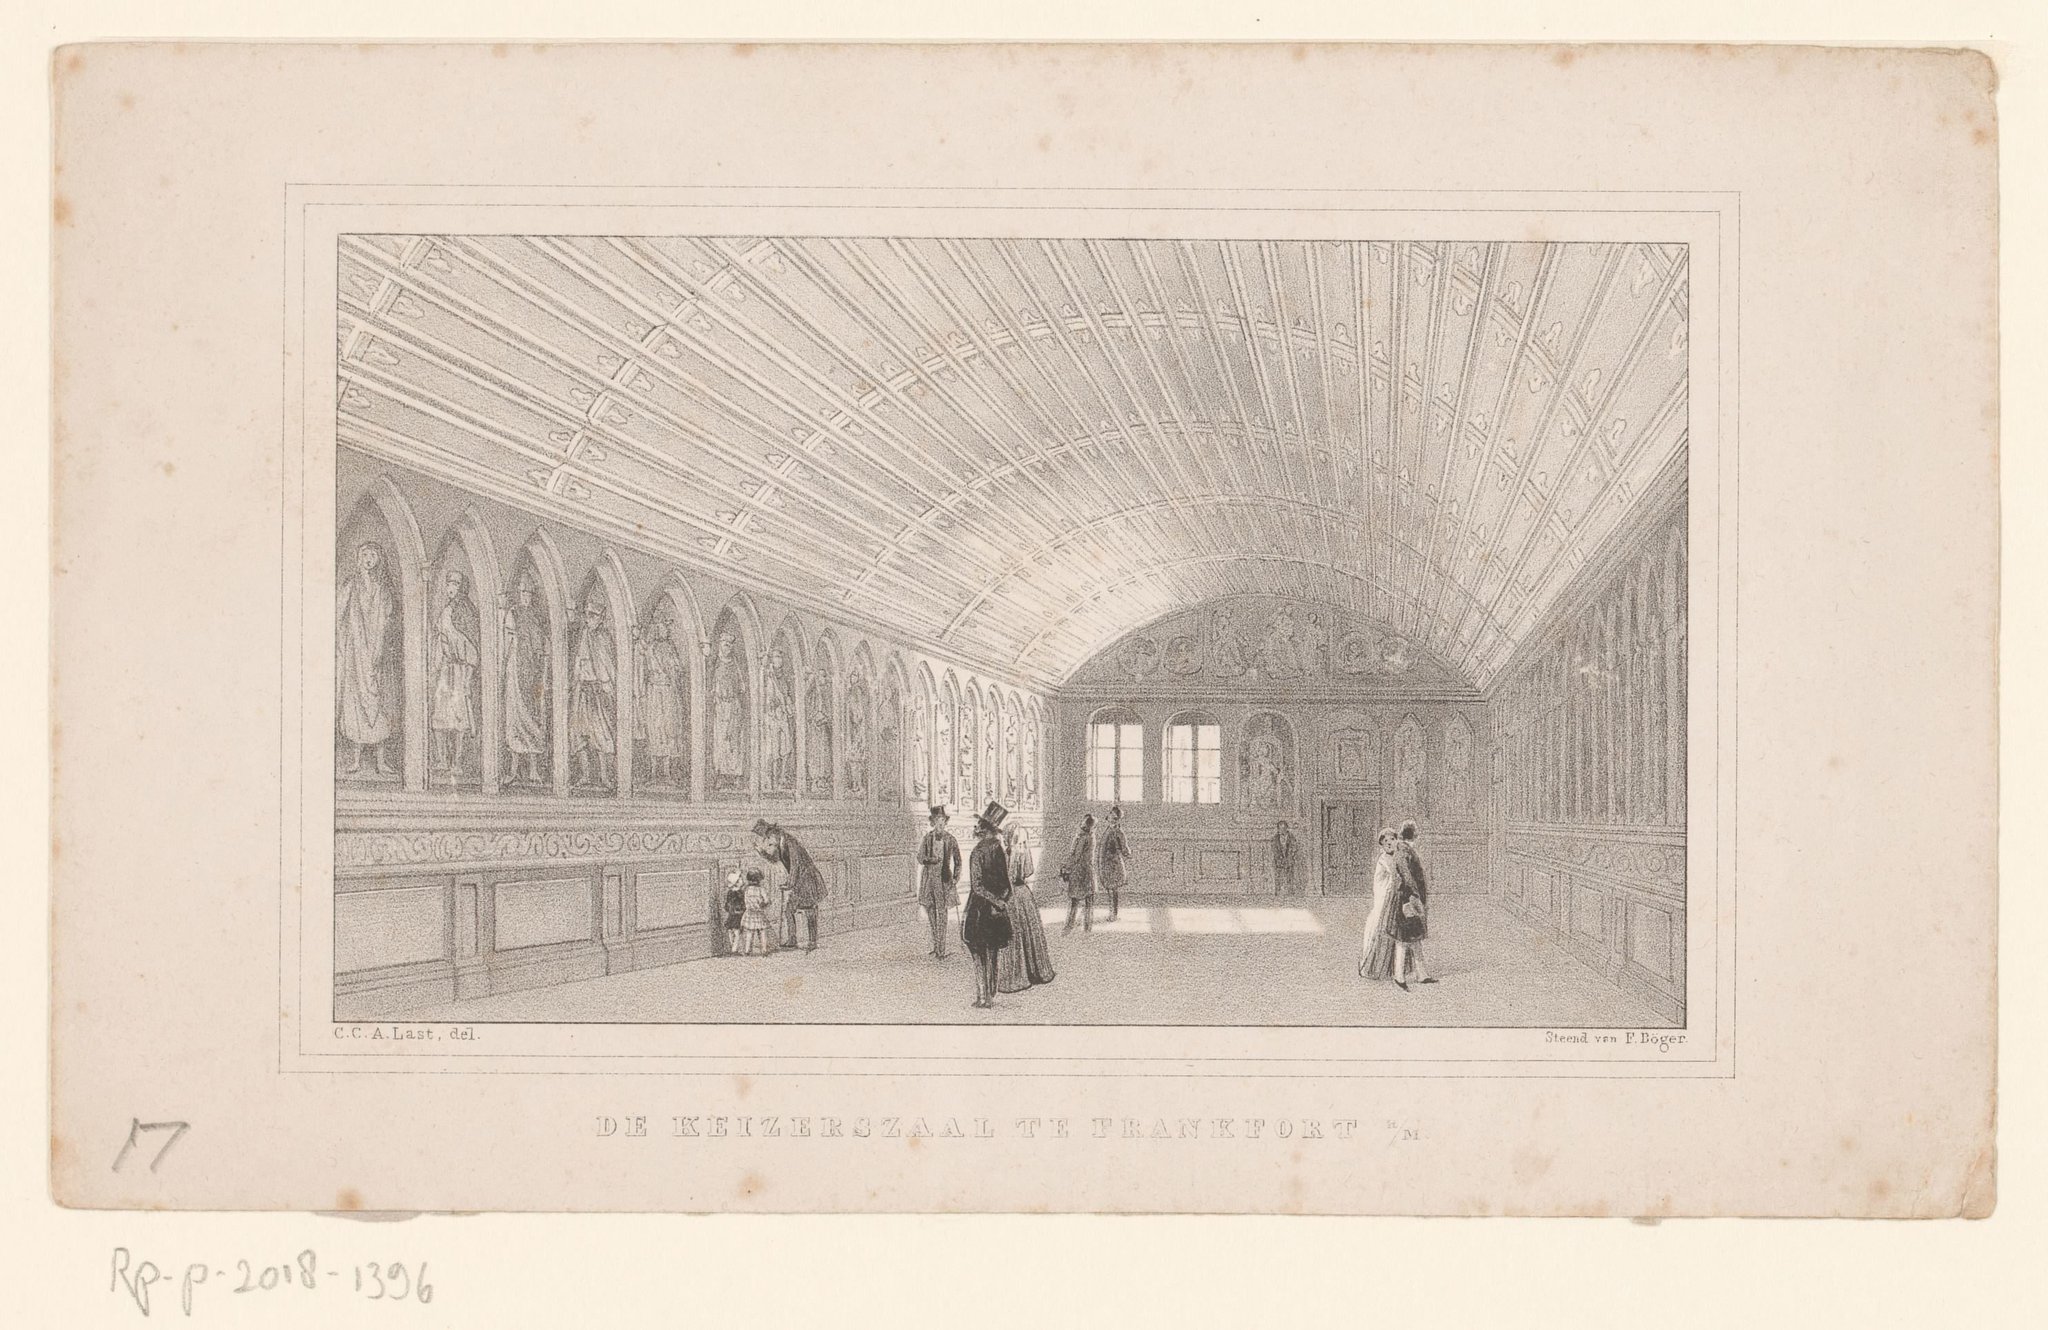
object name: print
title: Gezicht op de Kaisersaal in het Römer, te Frankfurt am Main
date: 1846-1880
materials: paper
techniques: lithograph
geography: dordrecht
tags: townhall, court-room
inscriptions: collector's mark: Lugt 2228